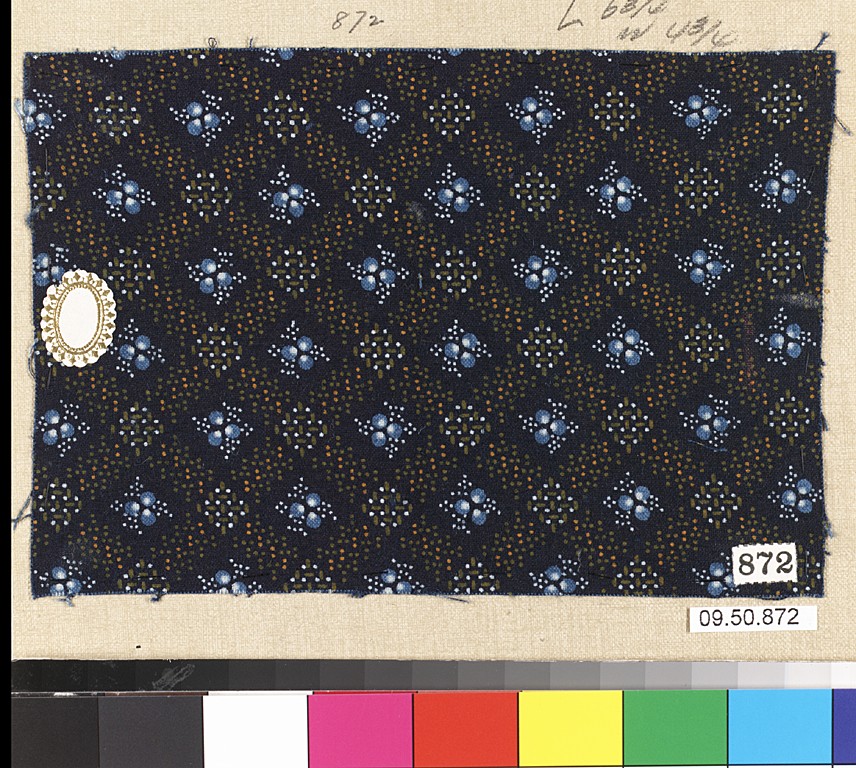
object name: piece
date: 1801-1900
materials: cotton